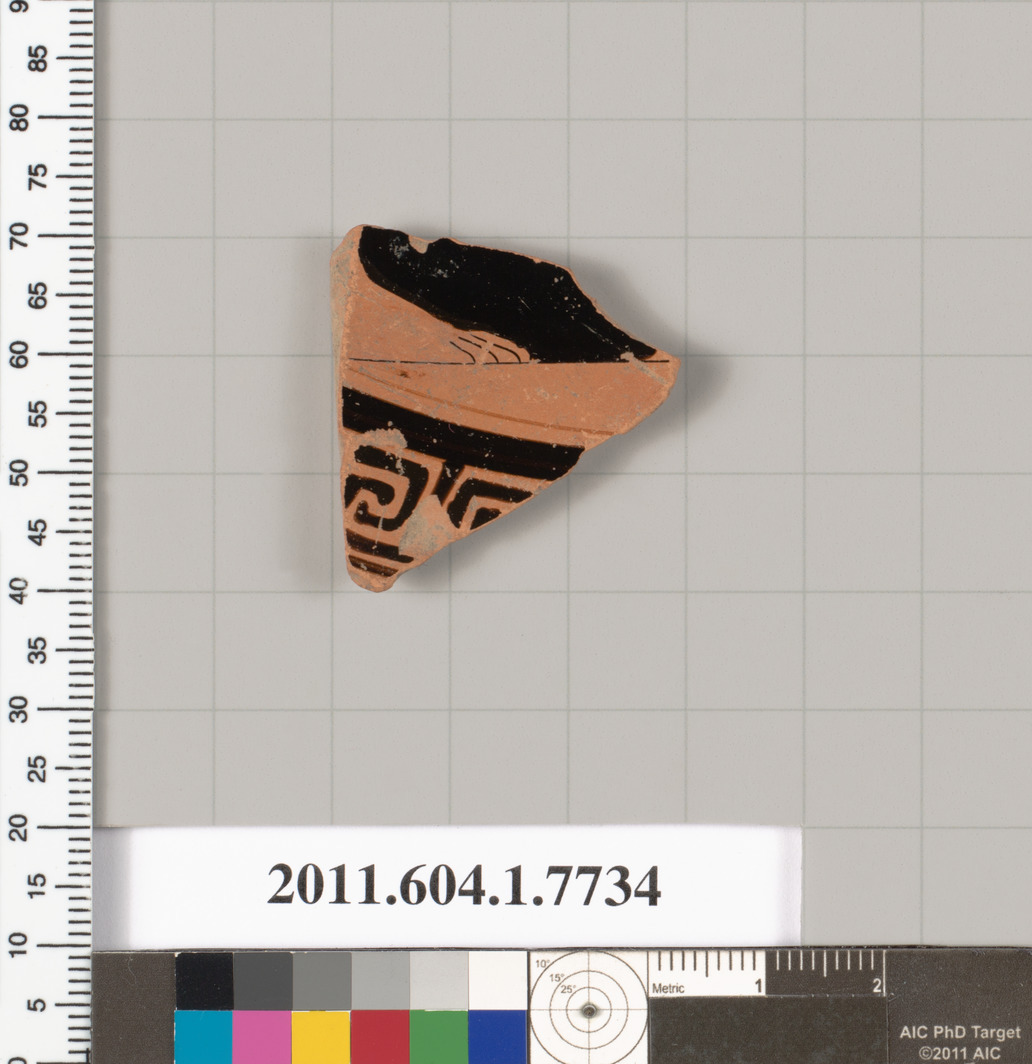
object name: kylix fragment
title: Terracotta fragment of a kylix (drinking cup)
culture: greek, attic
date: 460-450 BCE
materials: terracotta